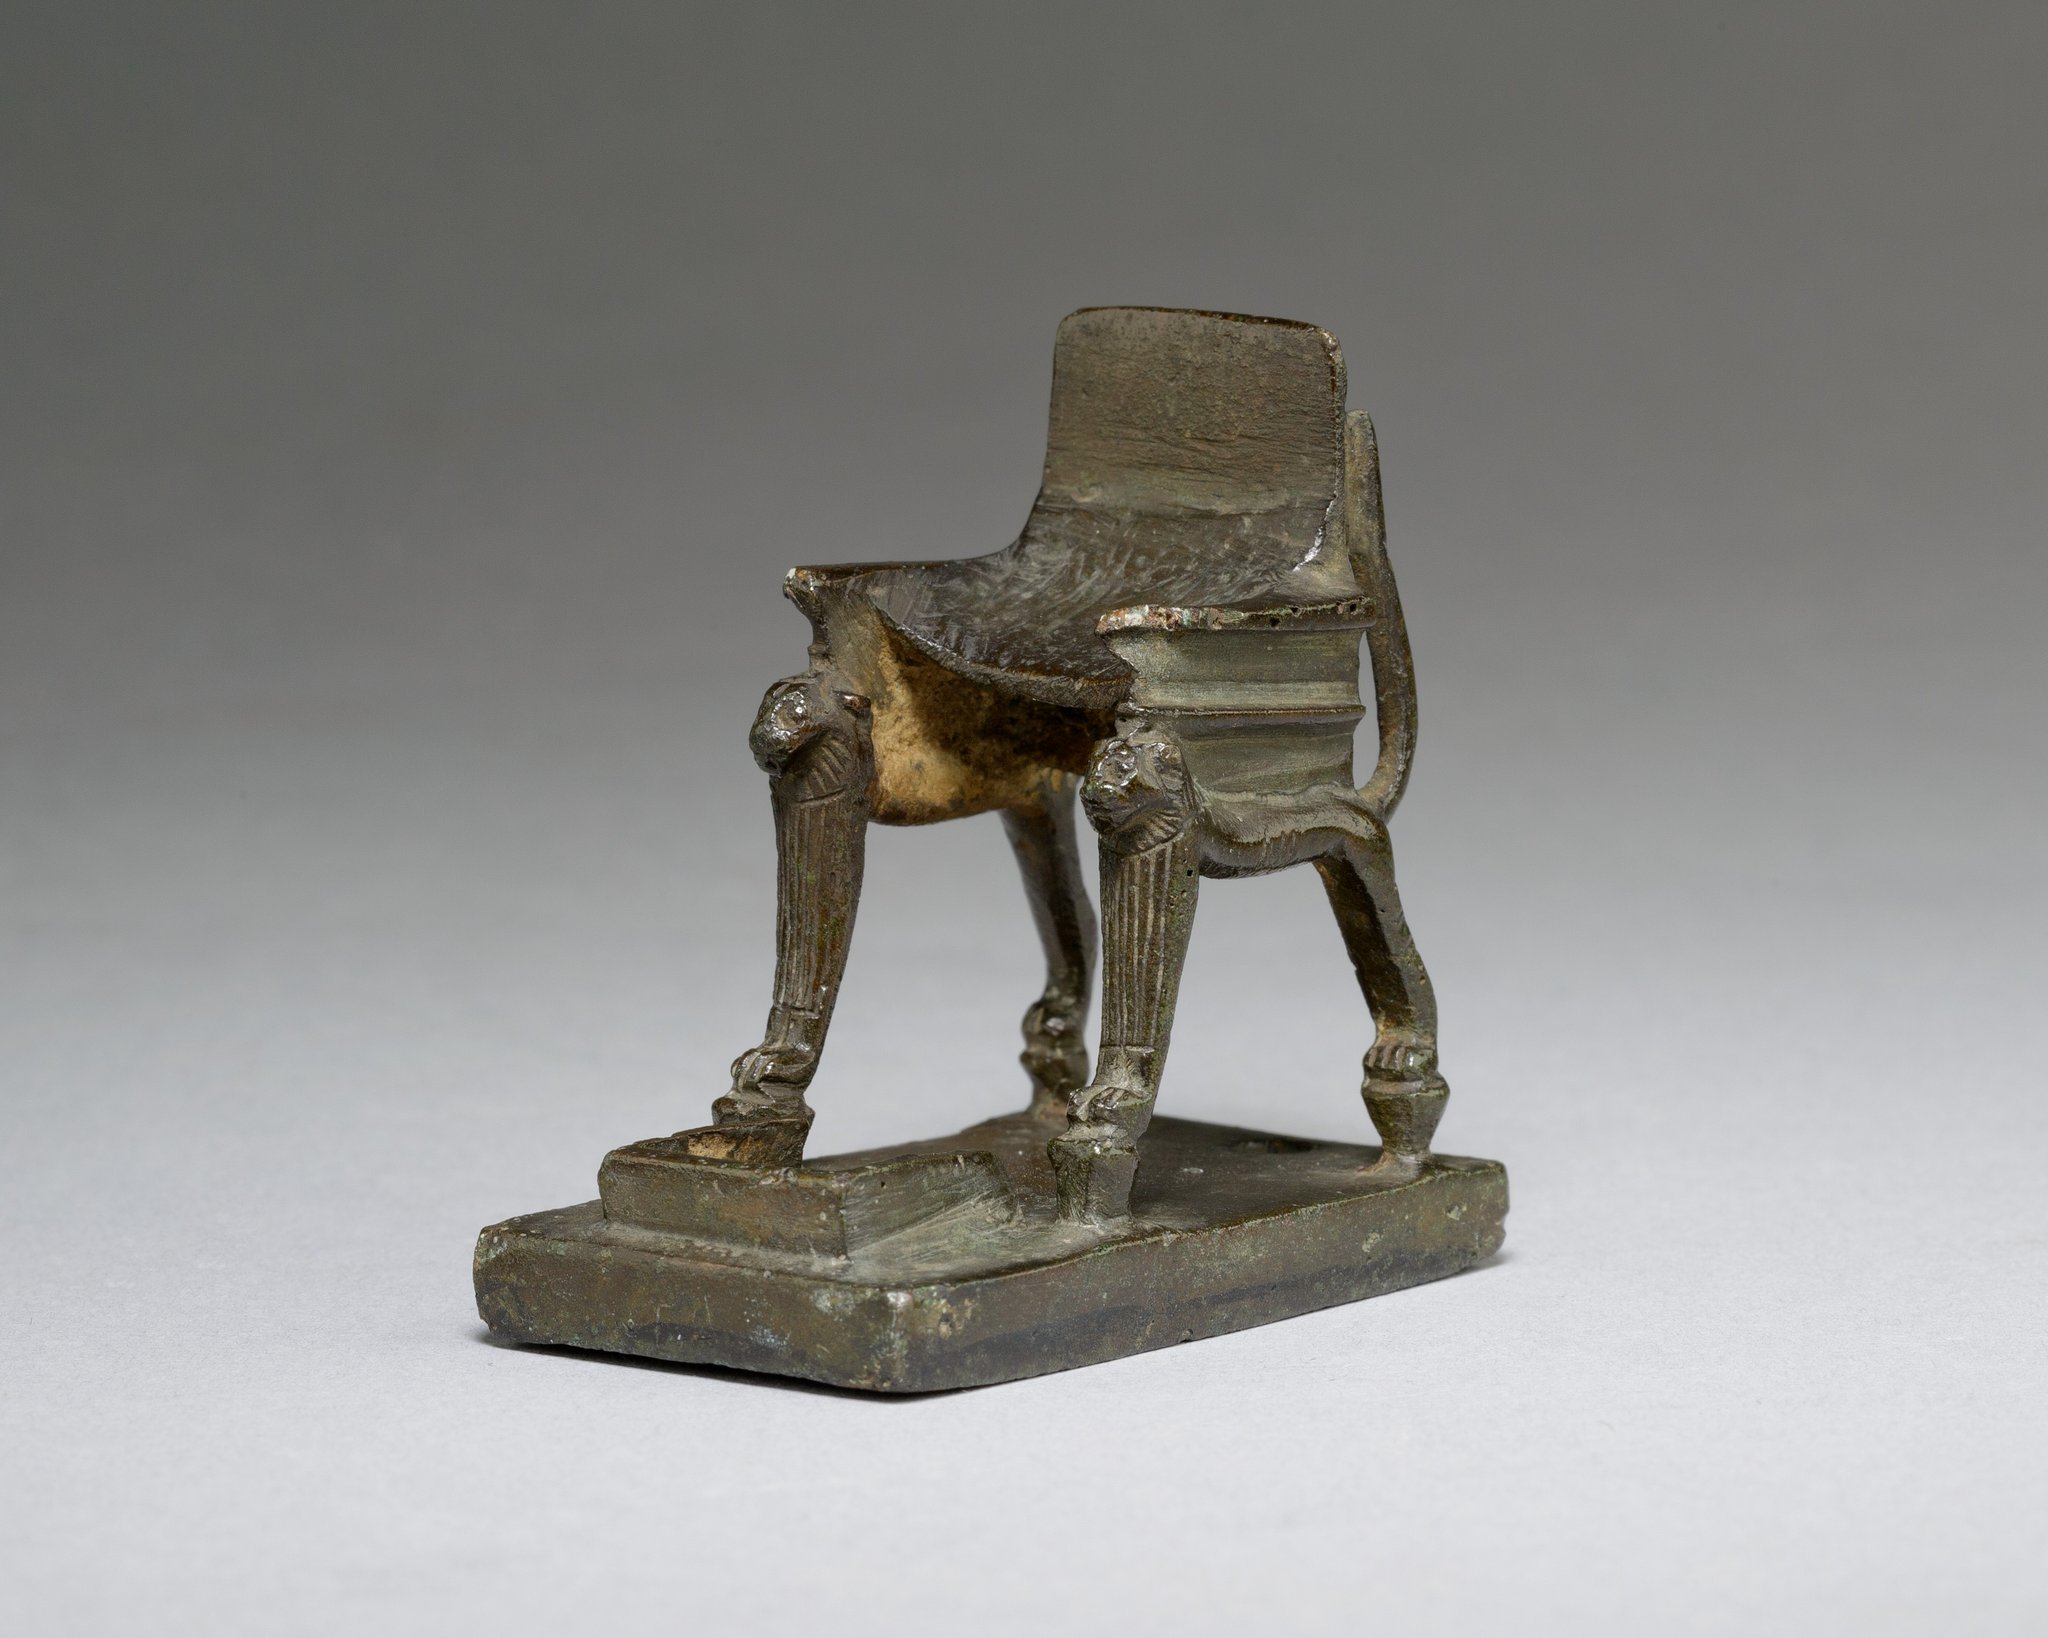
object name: amulet, throne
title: Throne for Statuette of a Deity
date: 664-332 BCE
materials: metal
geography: egypt